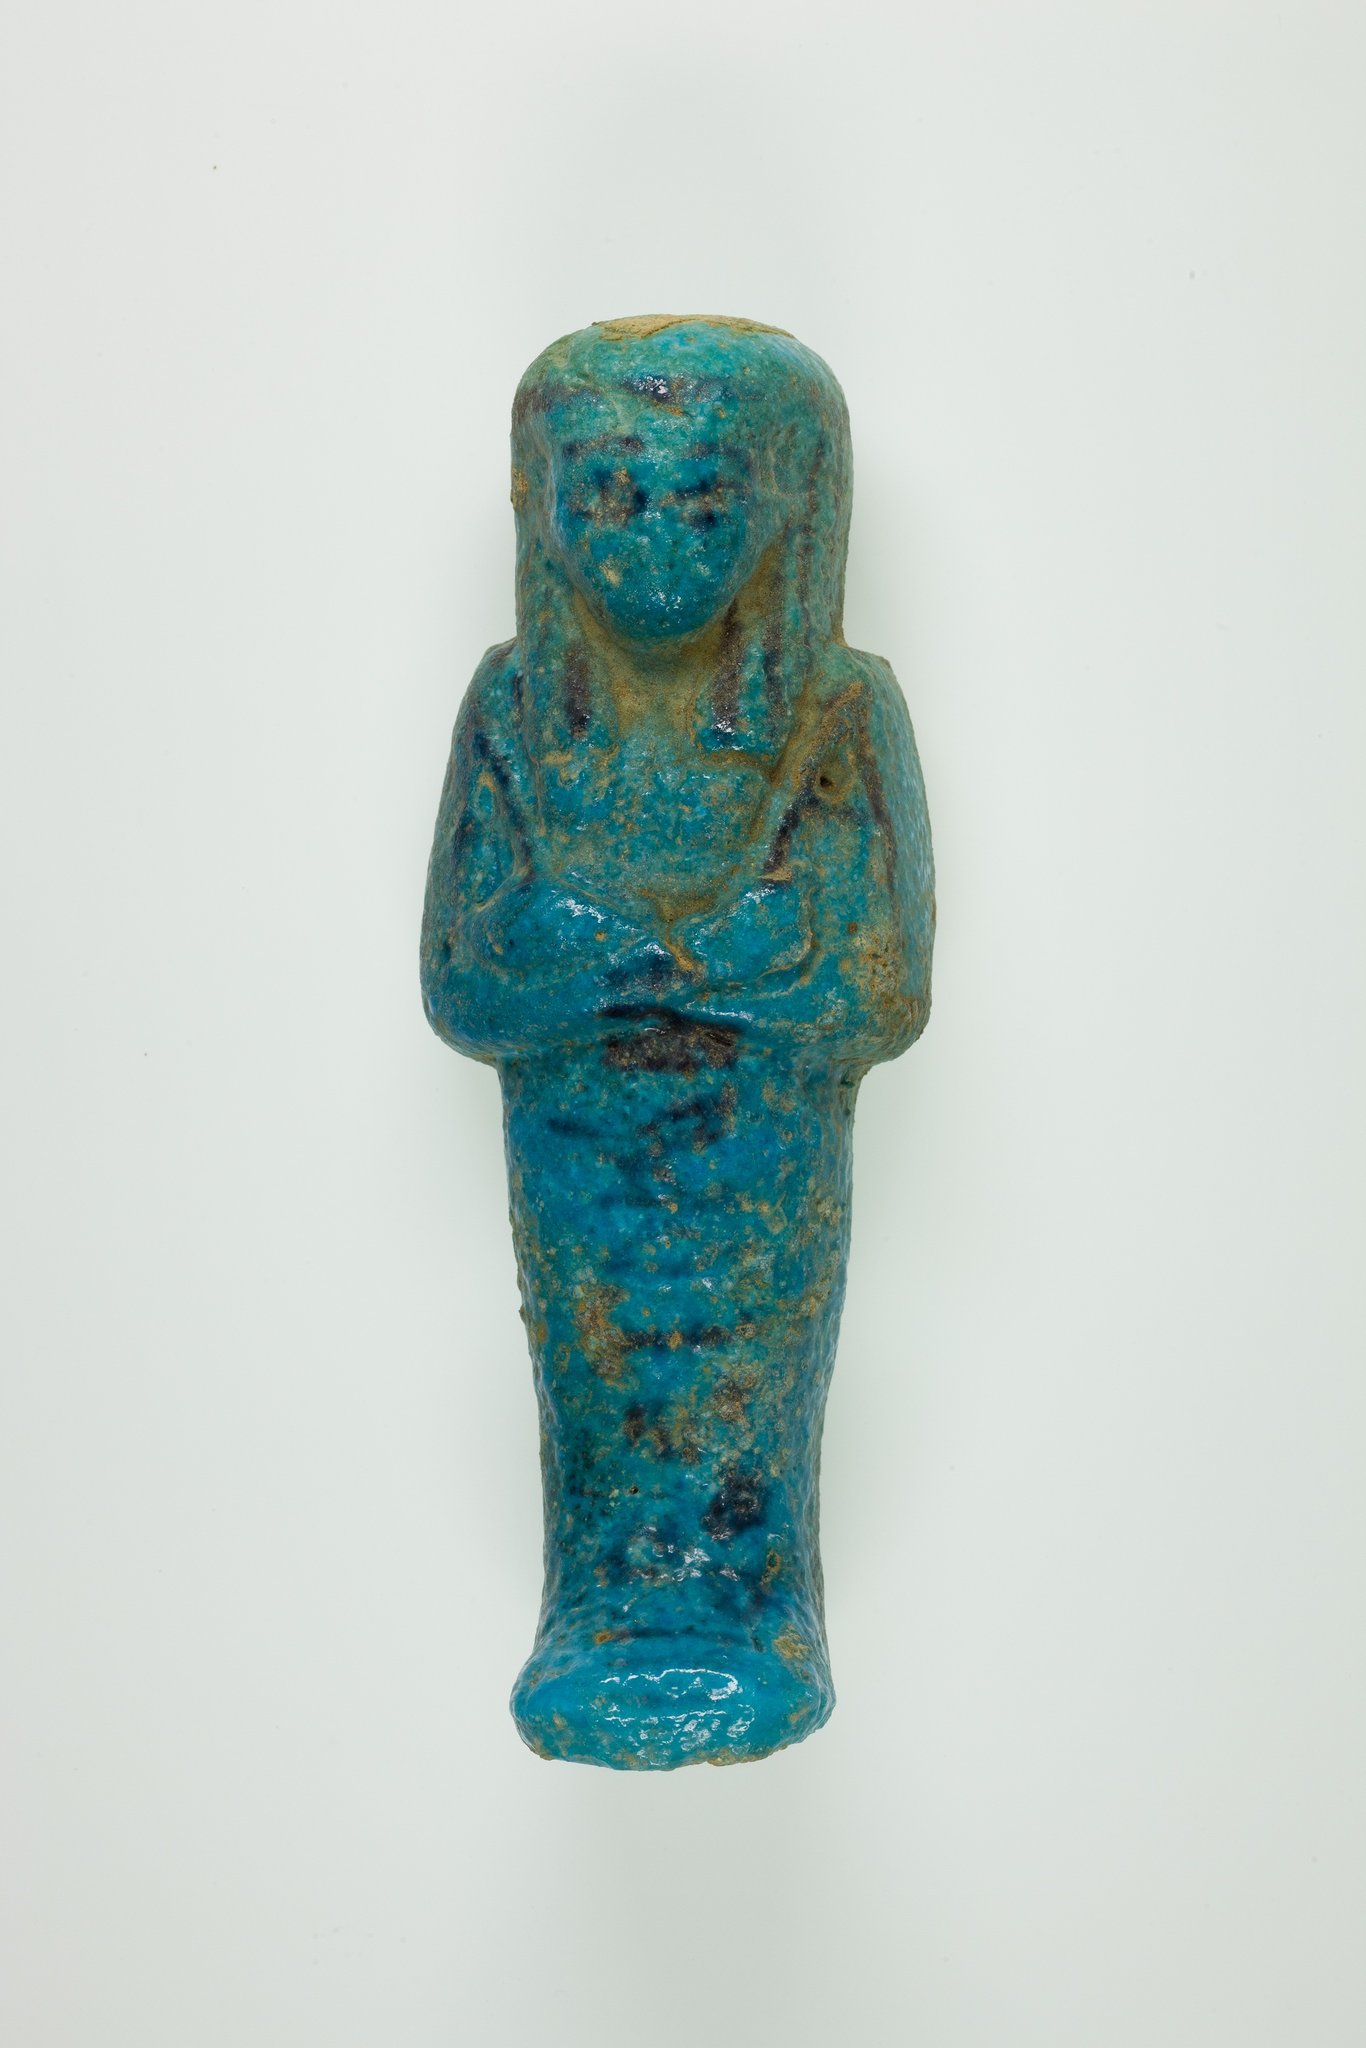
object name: worker shabti, henettawy c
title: Worker Shabti of Henettawy (C), Daughter of Isetemkheb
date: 990-970 BCE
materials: faience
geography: egypt